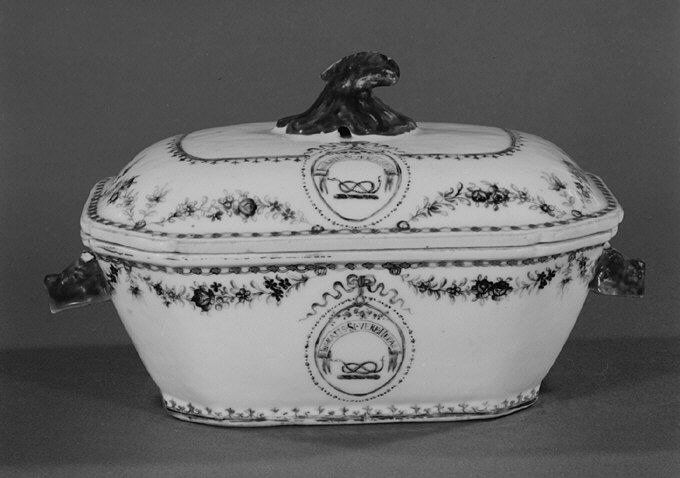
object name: sauceboat with cover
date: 1770-1780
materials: hard paste porcelain